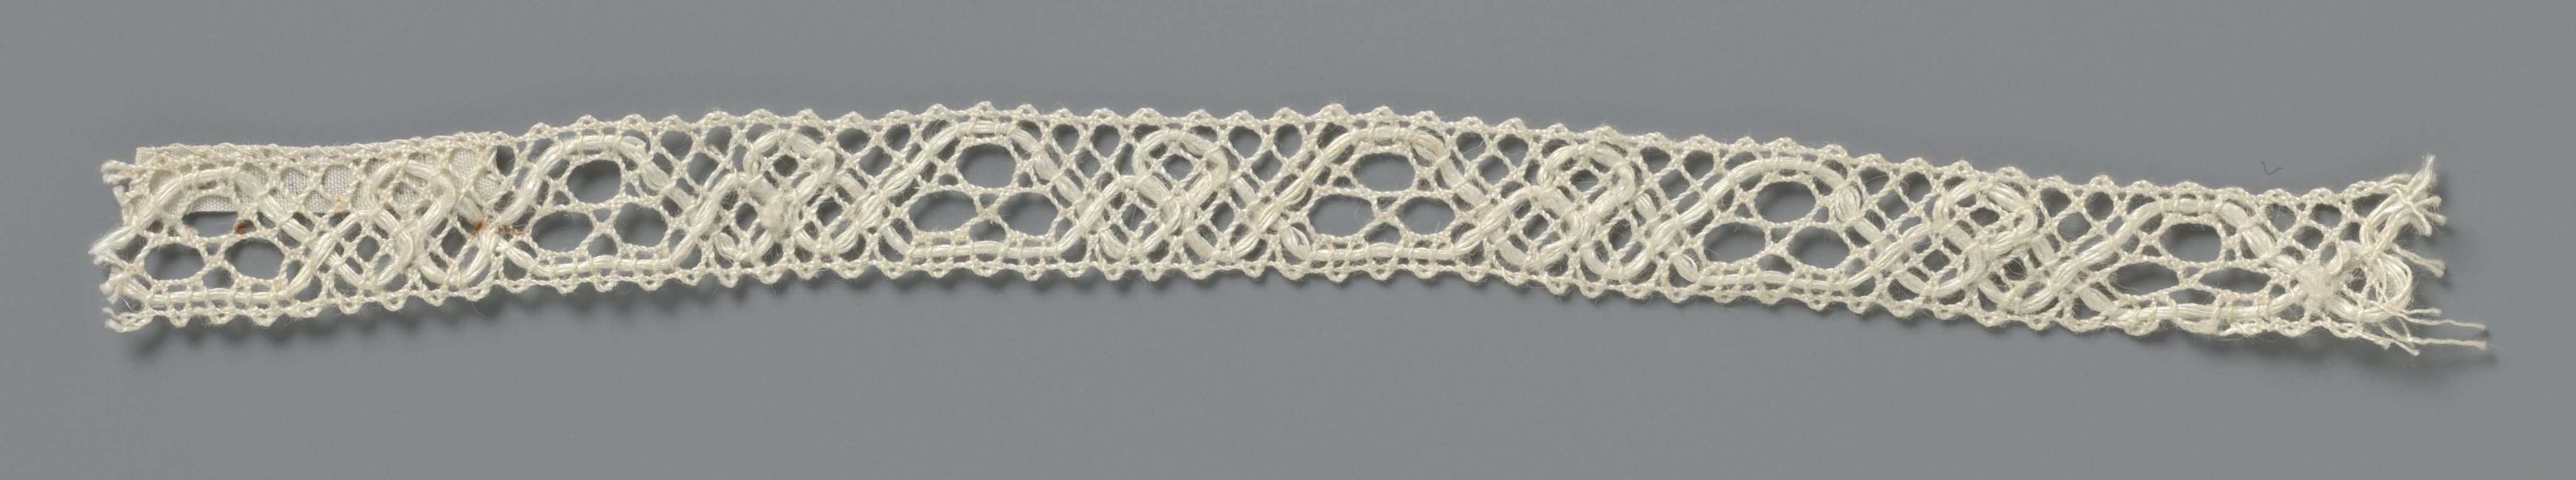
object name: strip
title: Strook kloskant met een aaneengesloten rij van cirkeltjes en trapeziumvormige veldjes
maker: Anonymous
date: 1800-1899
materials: linen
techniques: lace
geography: dalarna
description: Strook naturelkleurige kloskant, Zweedse kant. De strook is met spelden op een lichtblauw karton bevestigd, met zeven andere stroken. Boven de strook staat op het karton "Laces from Dalecarlia. (Dalarna)" geschreven. Het zich herhalende en doorgaande patroon wordt gevormd door een bundel draden, die door een maasgrond is gewerkt, een ruitvormige stroptraliegrond. Deze mazen worden onderbroken door een eenvoudige siergrond van steeds drie grotere ovale mazen. Rond deze drie ovale mazen vormt de dikke draad een trapeziumvormig veldje om vervolgens een configuratie van drie cirkelvormige veldjes te vormen in de stroptraliegrond en daarna weer een trapeziumvormig veldje rond de ovale mazen. En zo verder. Boven- en onderzijde van de strook zijn recht afgewerkt en voorzien van picots.